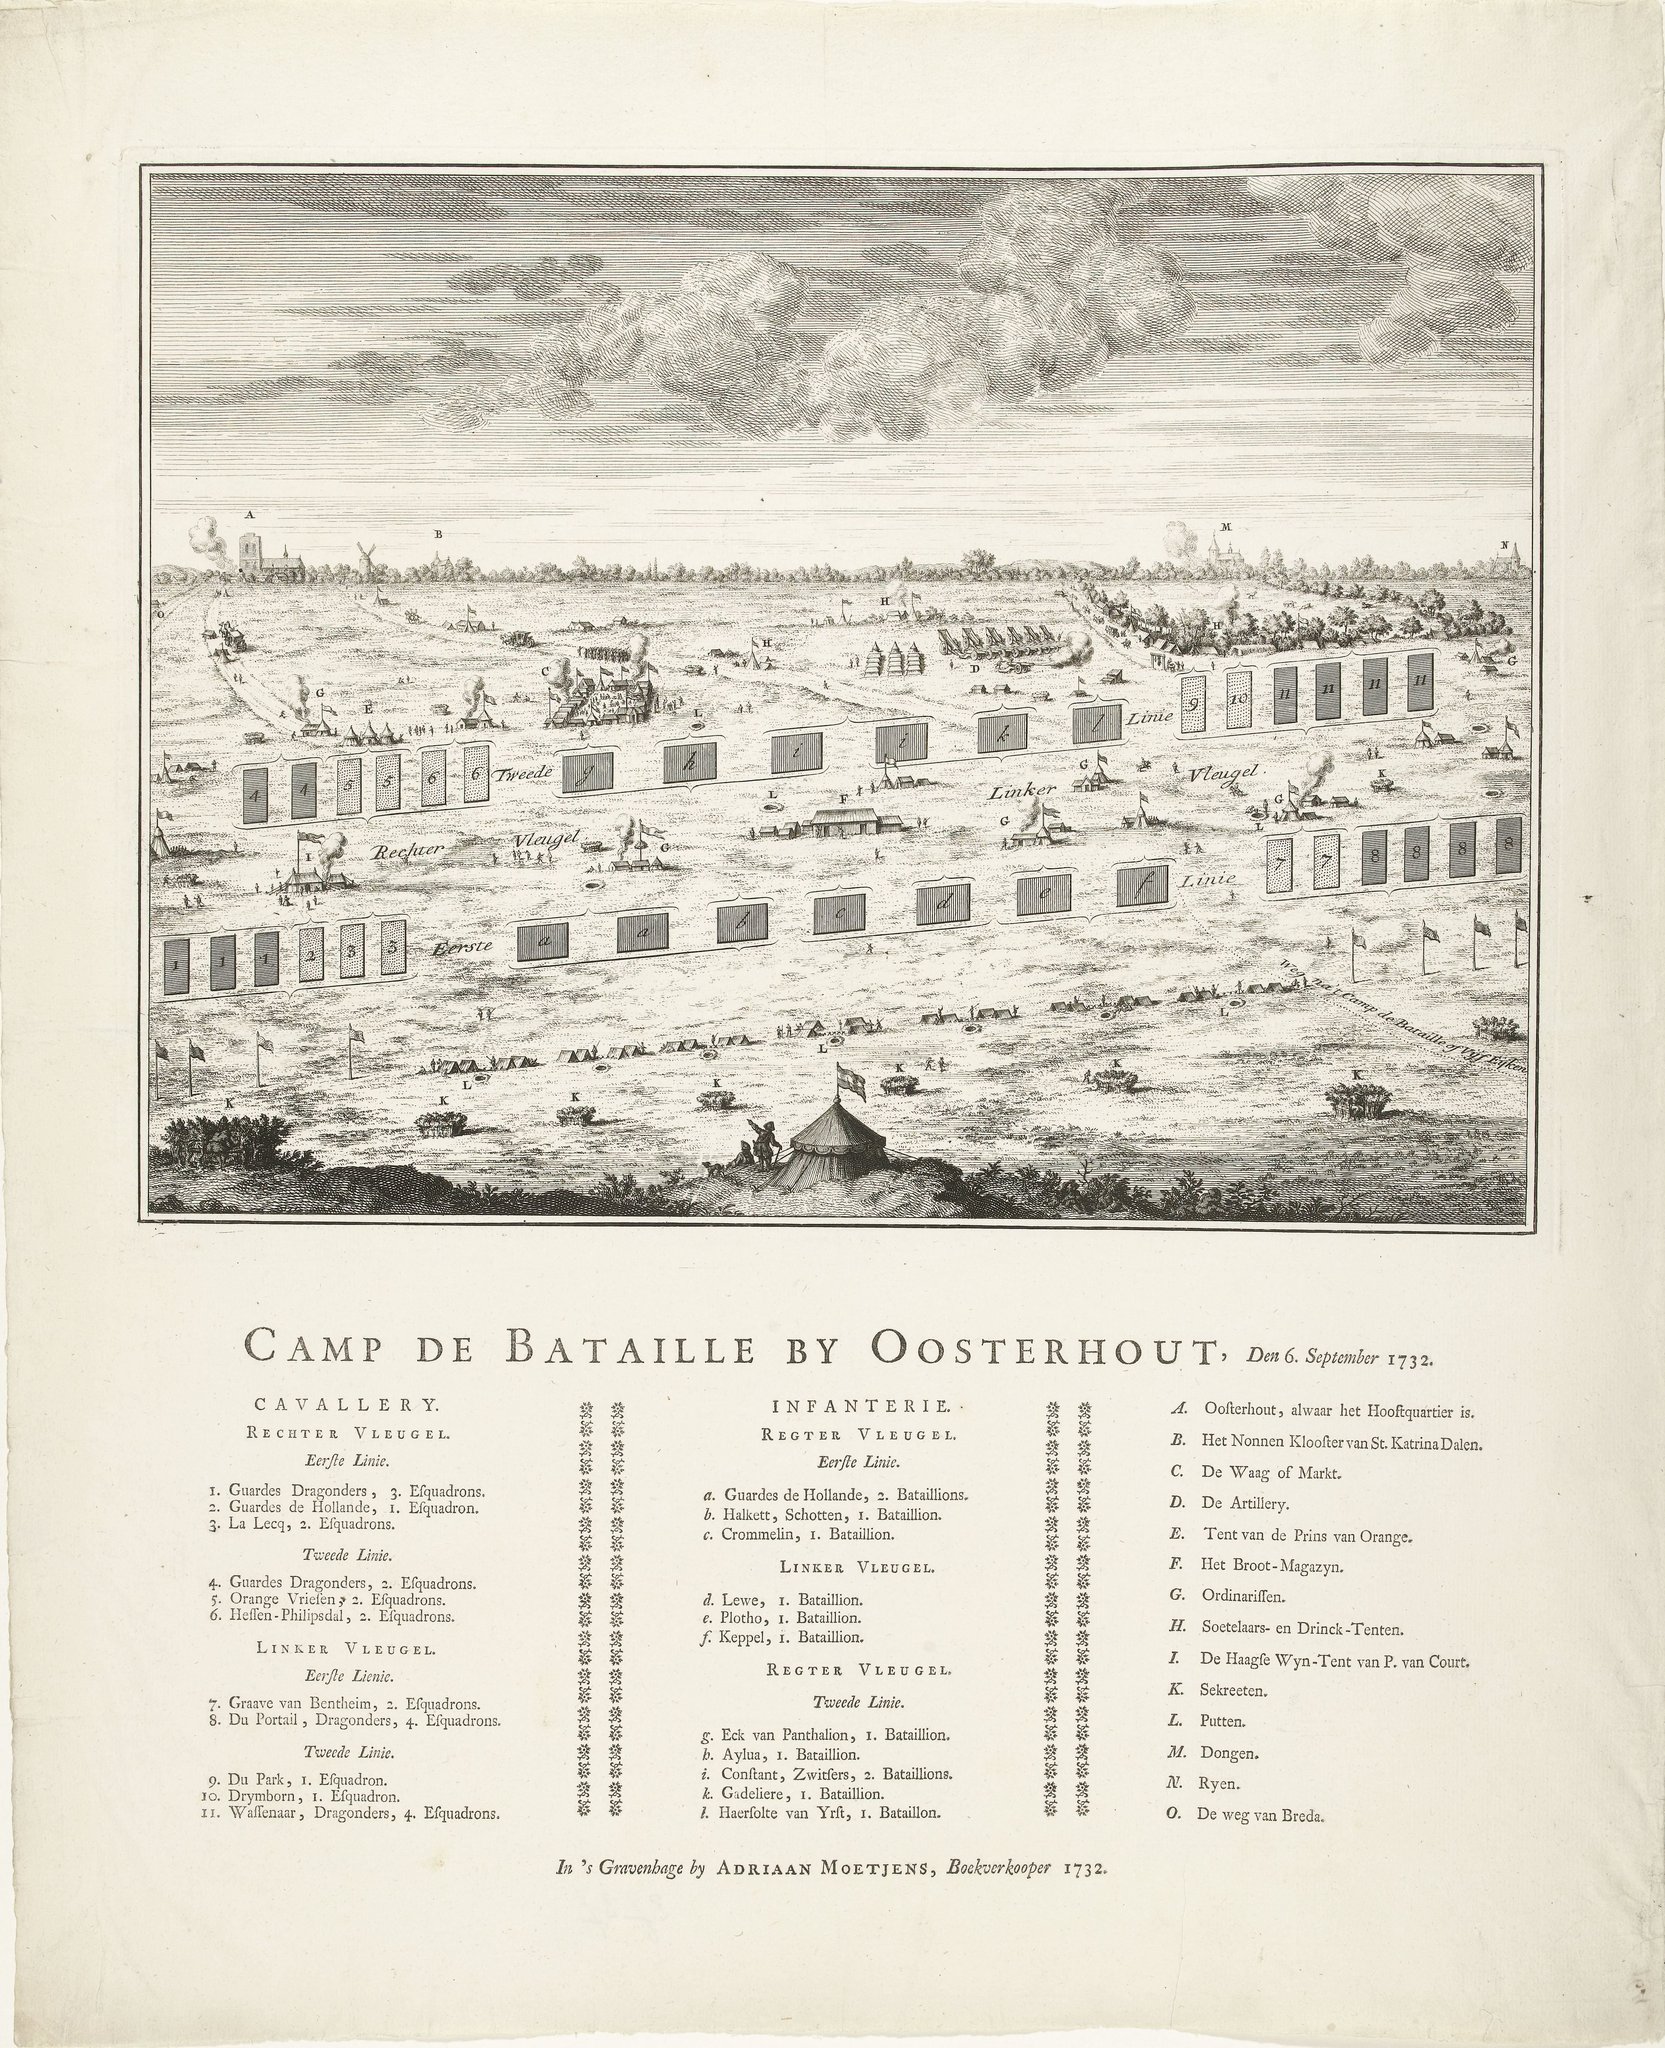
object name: print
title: Camp de Bataille by Oosterhout, Den 6. September 1732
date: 1732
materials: paper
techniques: etching, letterpress printing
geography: the hague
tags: (military) camp with tents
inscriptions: collector's mark: Lugt 2228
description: Plattegrond van het Hollandse legerkamp tijdens het Kampement van Oosterhout op de heide bij Oosterhout, 6 september 1732. Onder de plaat een lijst van de eskadrons cavalerie (1-11) en de bataljons infanterie (a-l) en de legenda A-O.